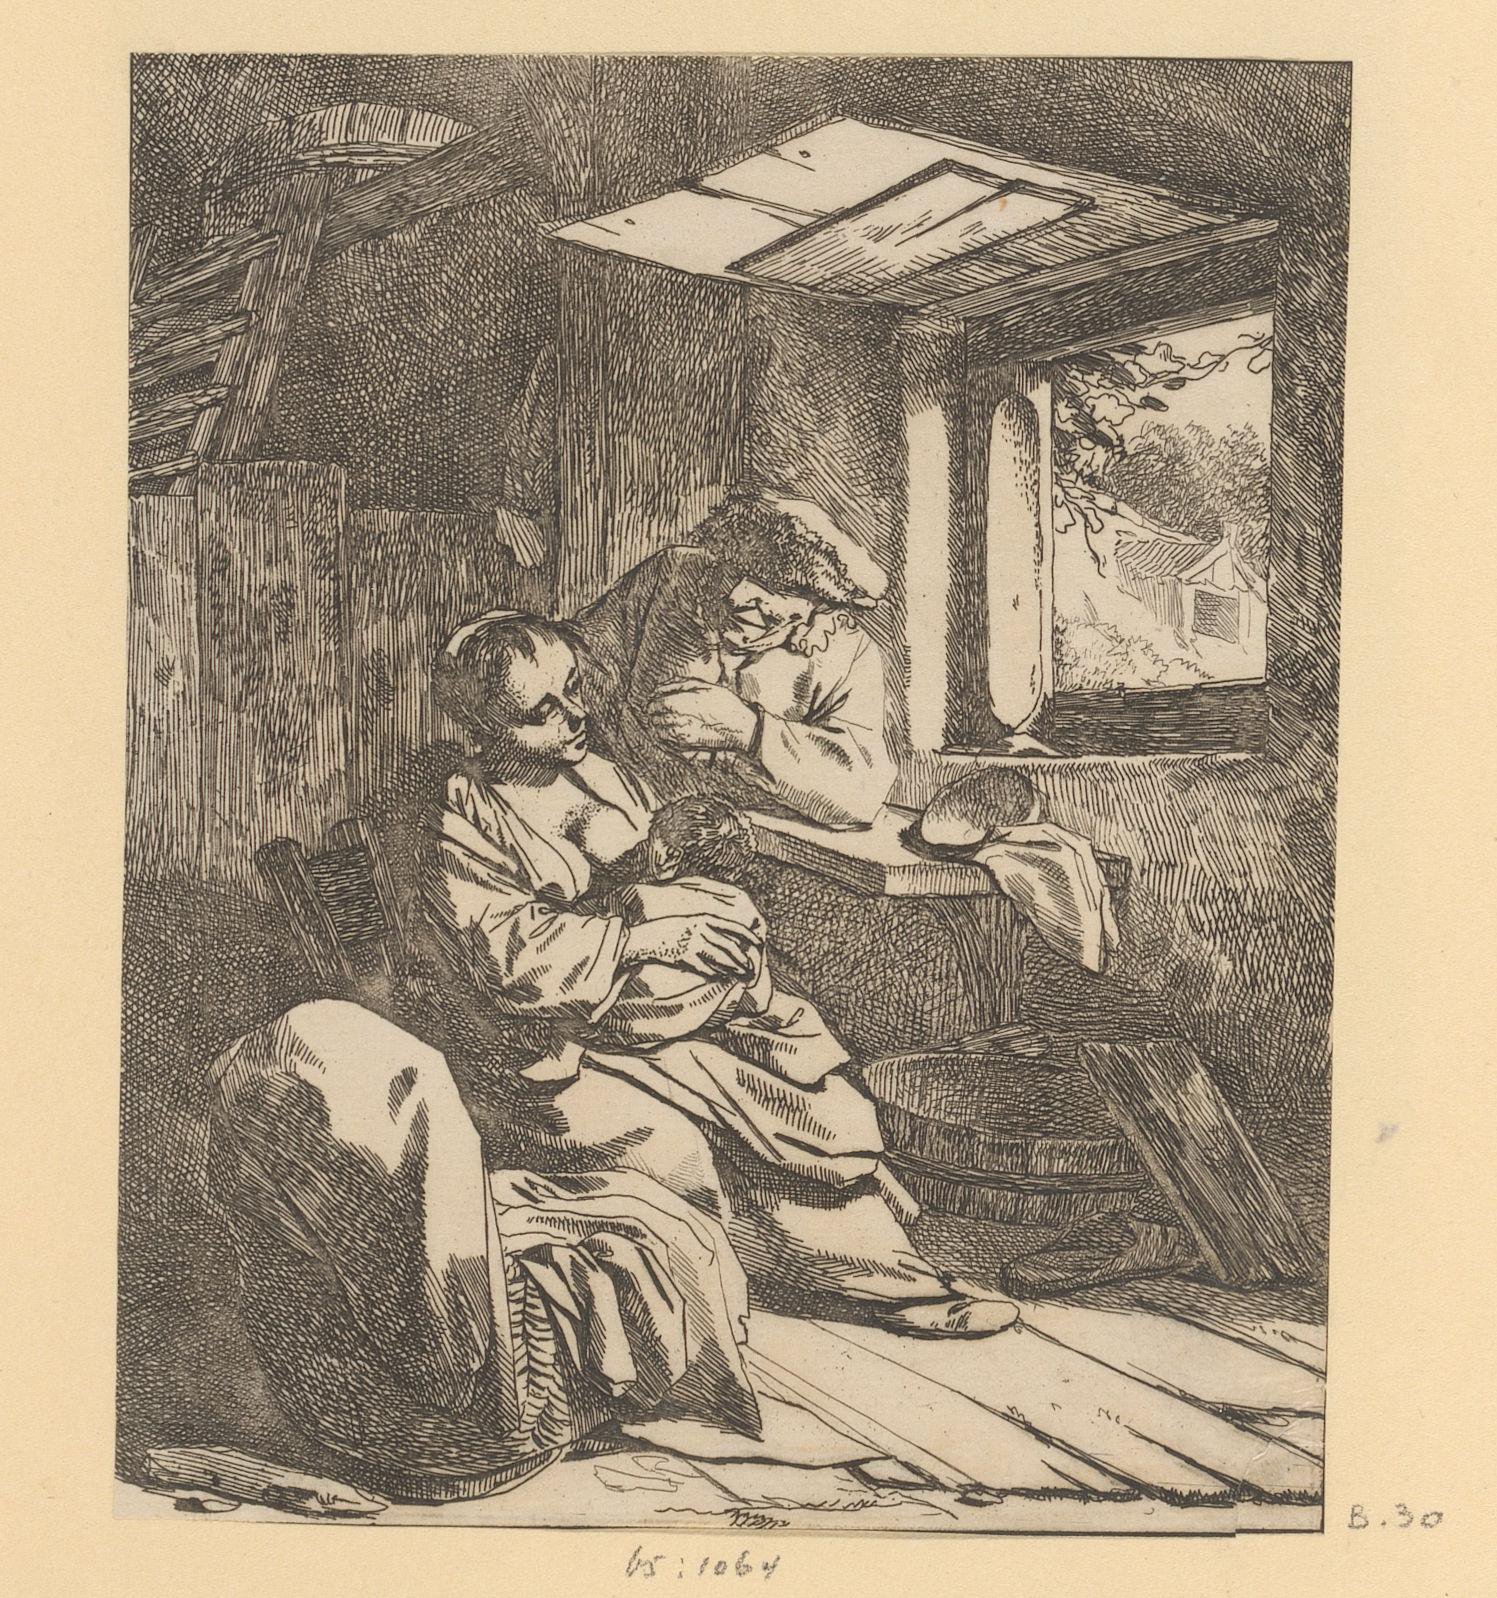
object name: print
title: Vrouw met kind en man bij wieg in interieur met open raam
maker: cornelis pietersz. bega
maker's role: draughtsman, painter, print maker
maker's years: 1631-1664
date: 1642-1664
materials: paper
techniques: etching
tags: mother and baby or young child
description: Prent maakt mogelijk deel uit van een serie van 200 prenten. Deze serie is onder de titel 'A Collection of two hundred original etchings' voor het eerst uitgegeven door J.M. Greery in 1816.